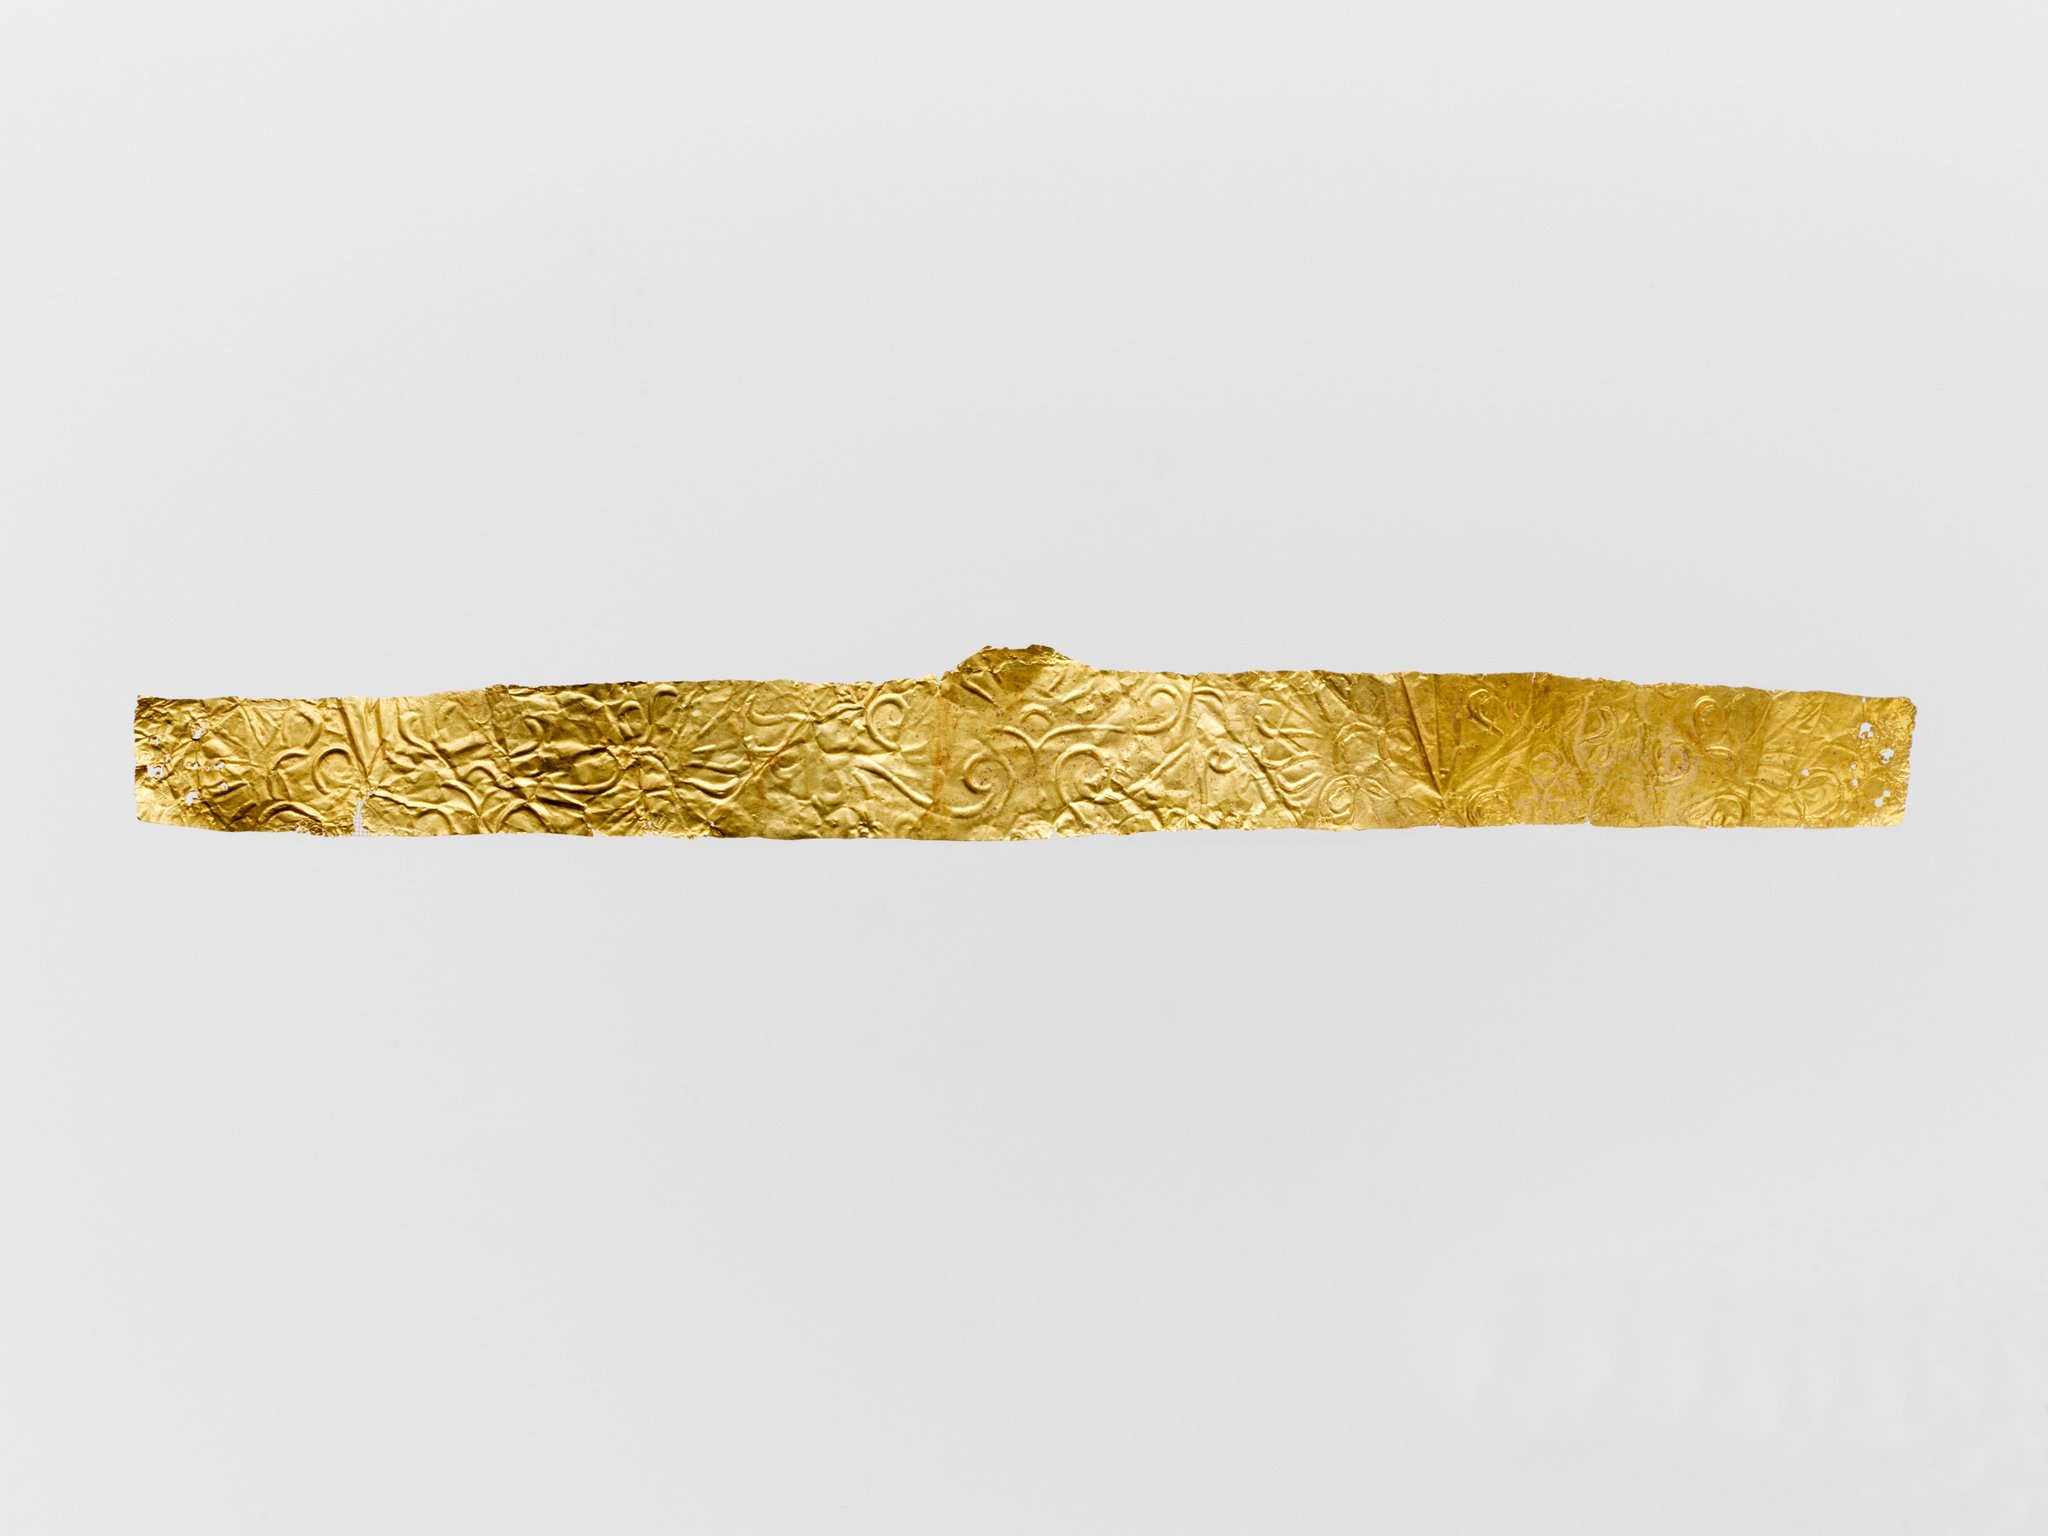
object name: diadem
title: Gold diadem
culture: cypriot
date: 400-301 BCE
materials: gold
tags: diadems